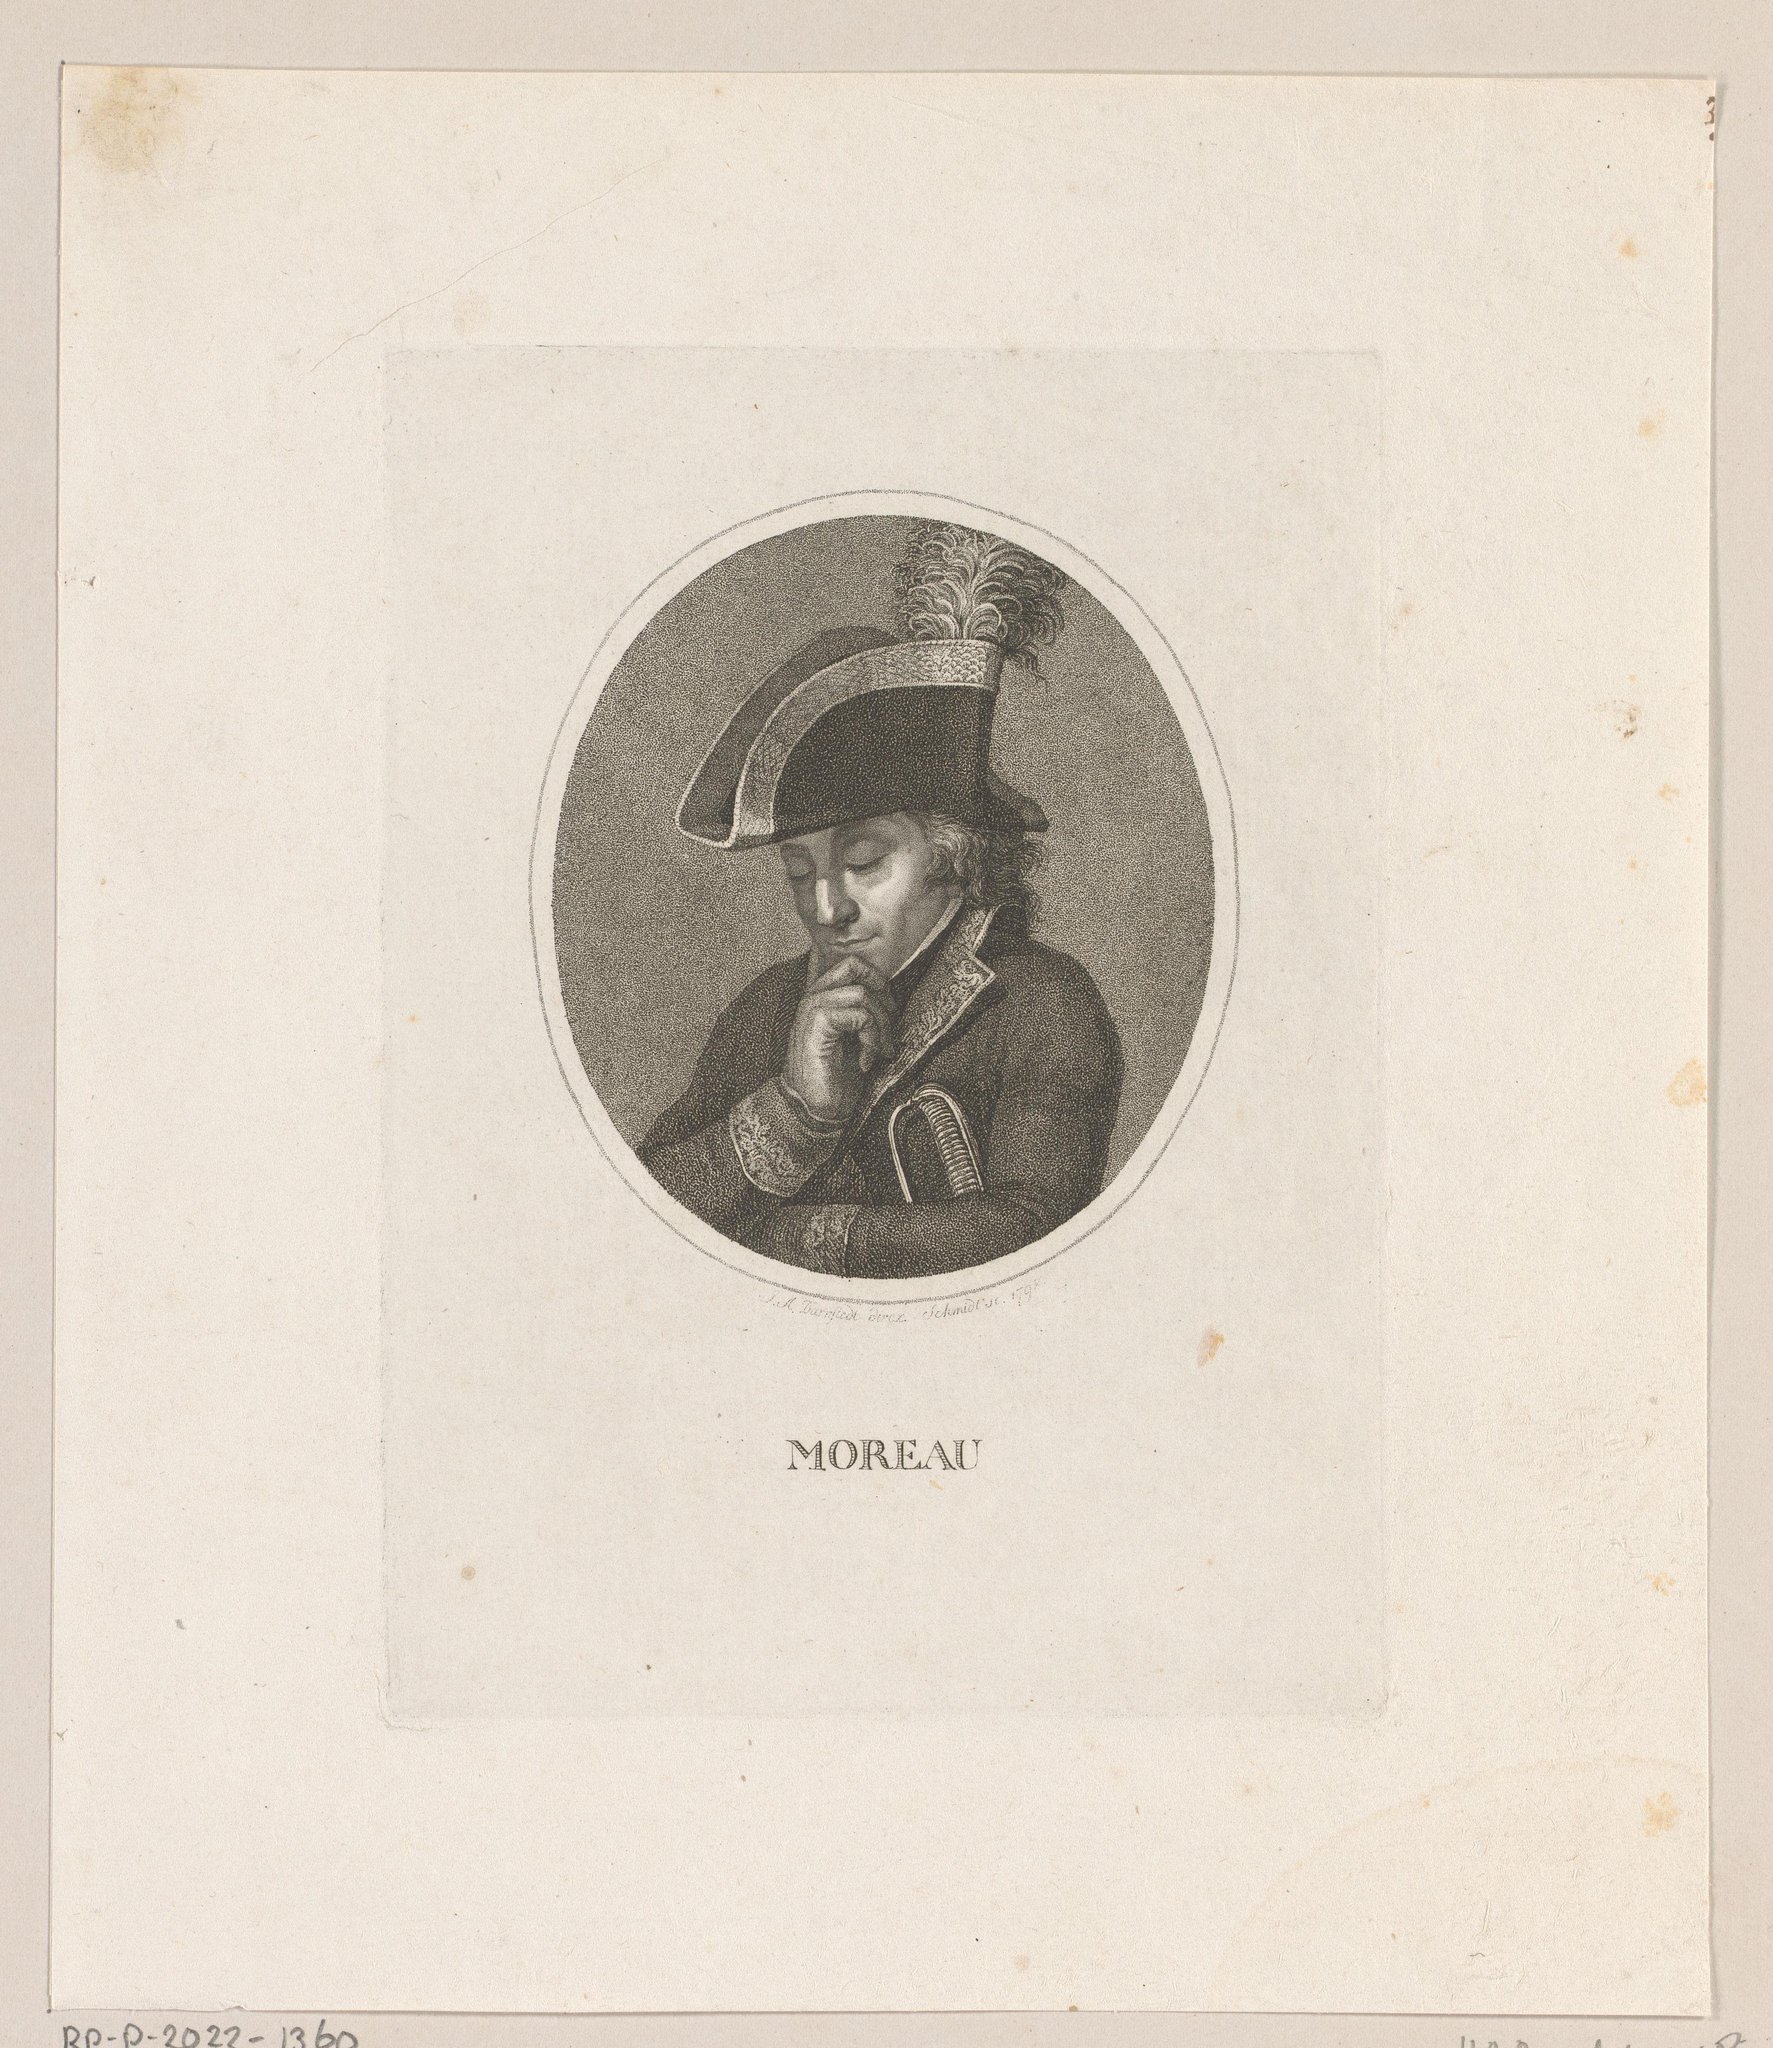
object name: print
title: Moreau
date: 1798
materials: paper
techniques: etching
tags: commander-in-chief, general, marshal, historical persons